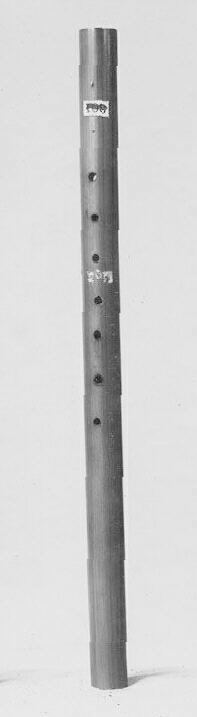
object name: flute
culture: malagasy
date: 1867-1900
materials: bamboo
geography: madagascar